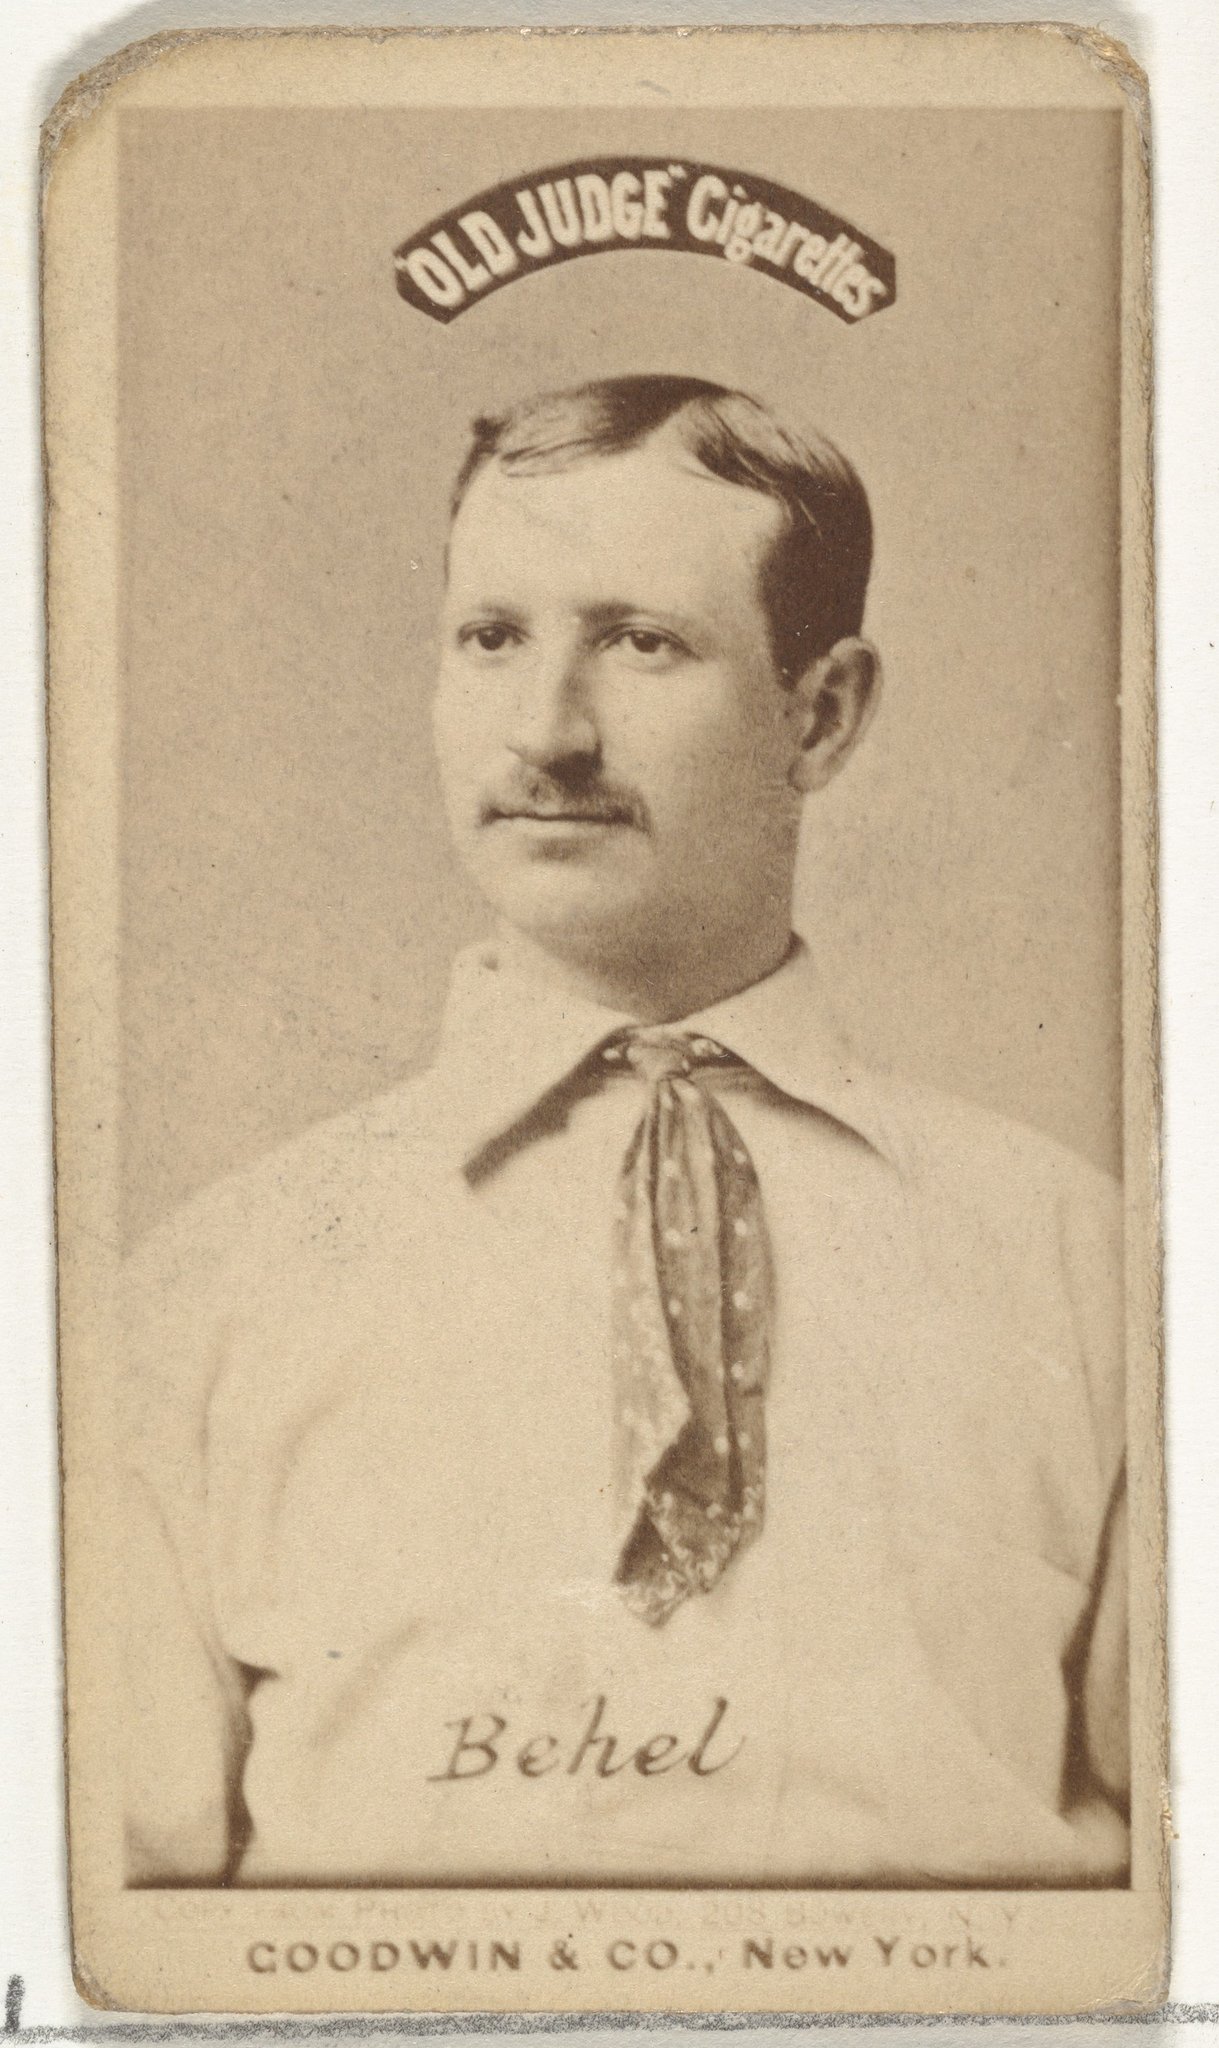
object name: baseball card, photograph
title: Stephen Arnold Douglas "Steve" Behel, New York Metropolitans, from the Old Judge series (N172) for Old Judge Cigarettes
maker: goodwin & company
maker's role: publisher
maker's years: 1850-1950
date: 1887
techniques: albumen silver print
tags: men,portraits,baseball,athletes